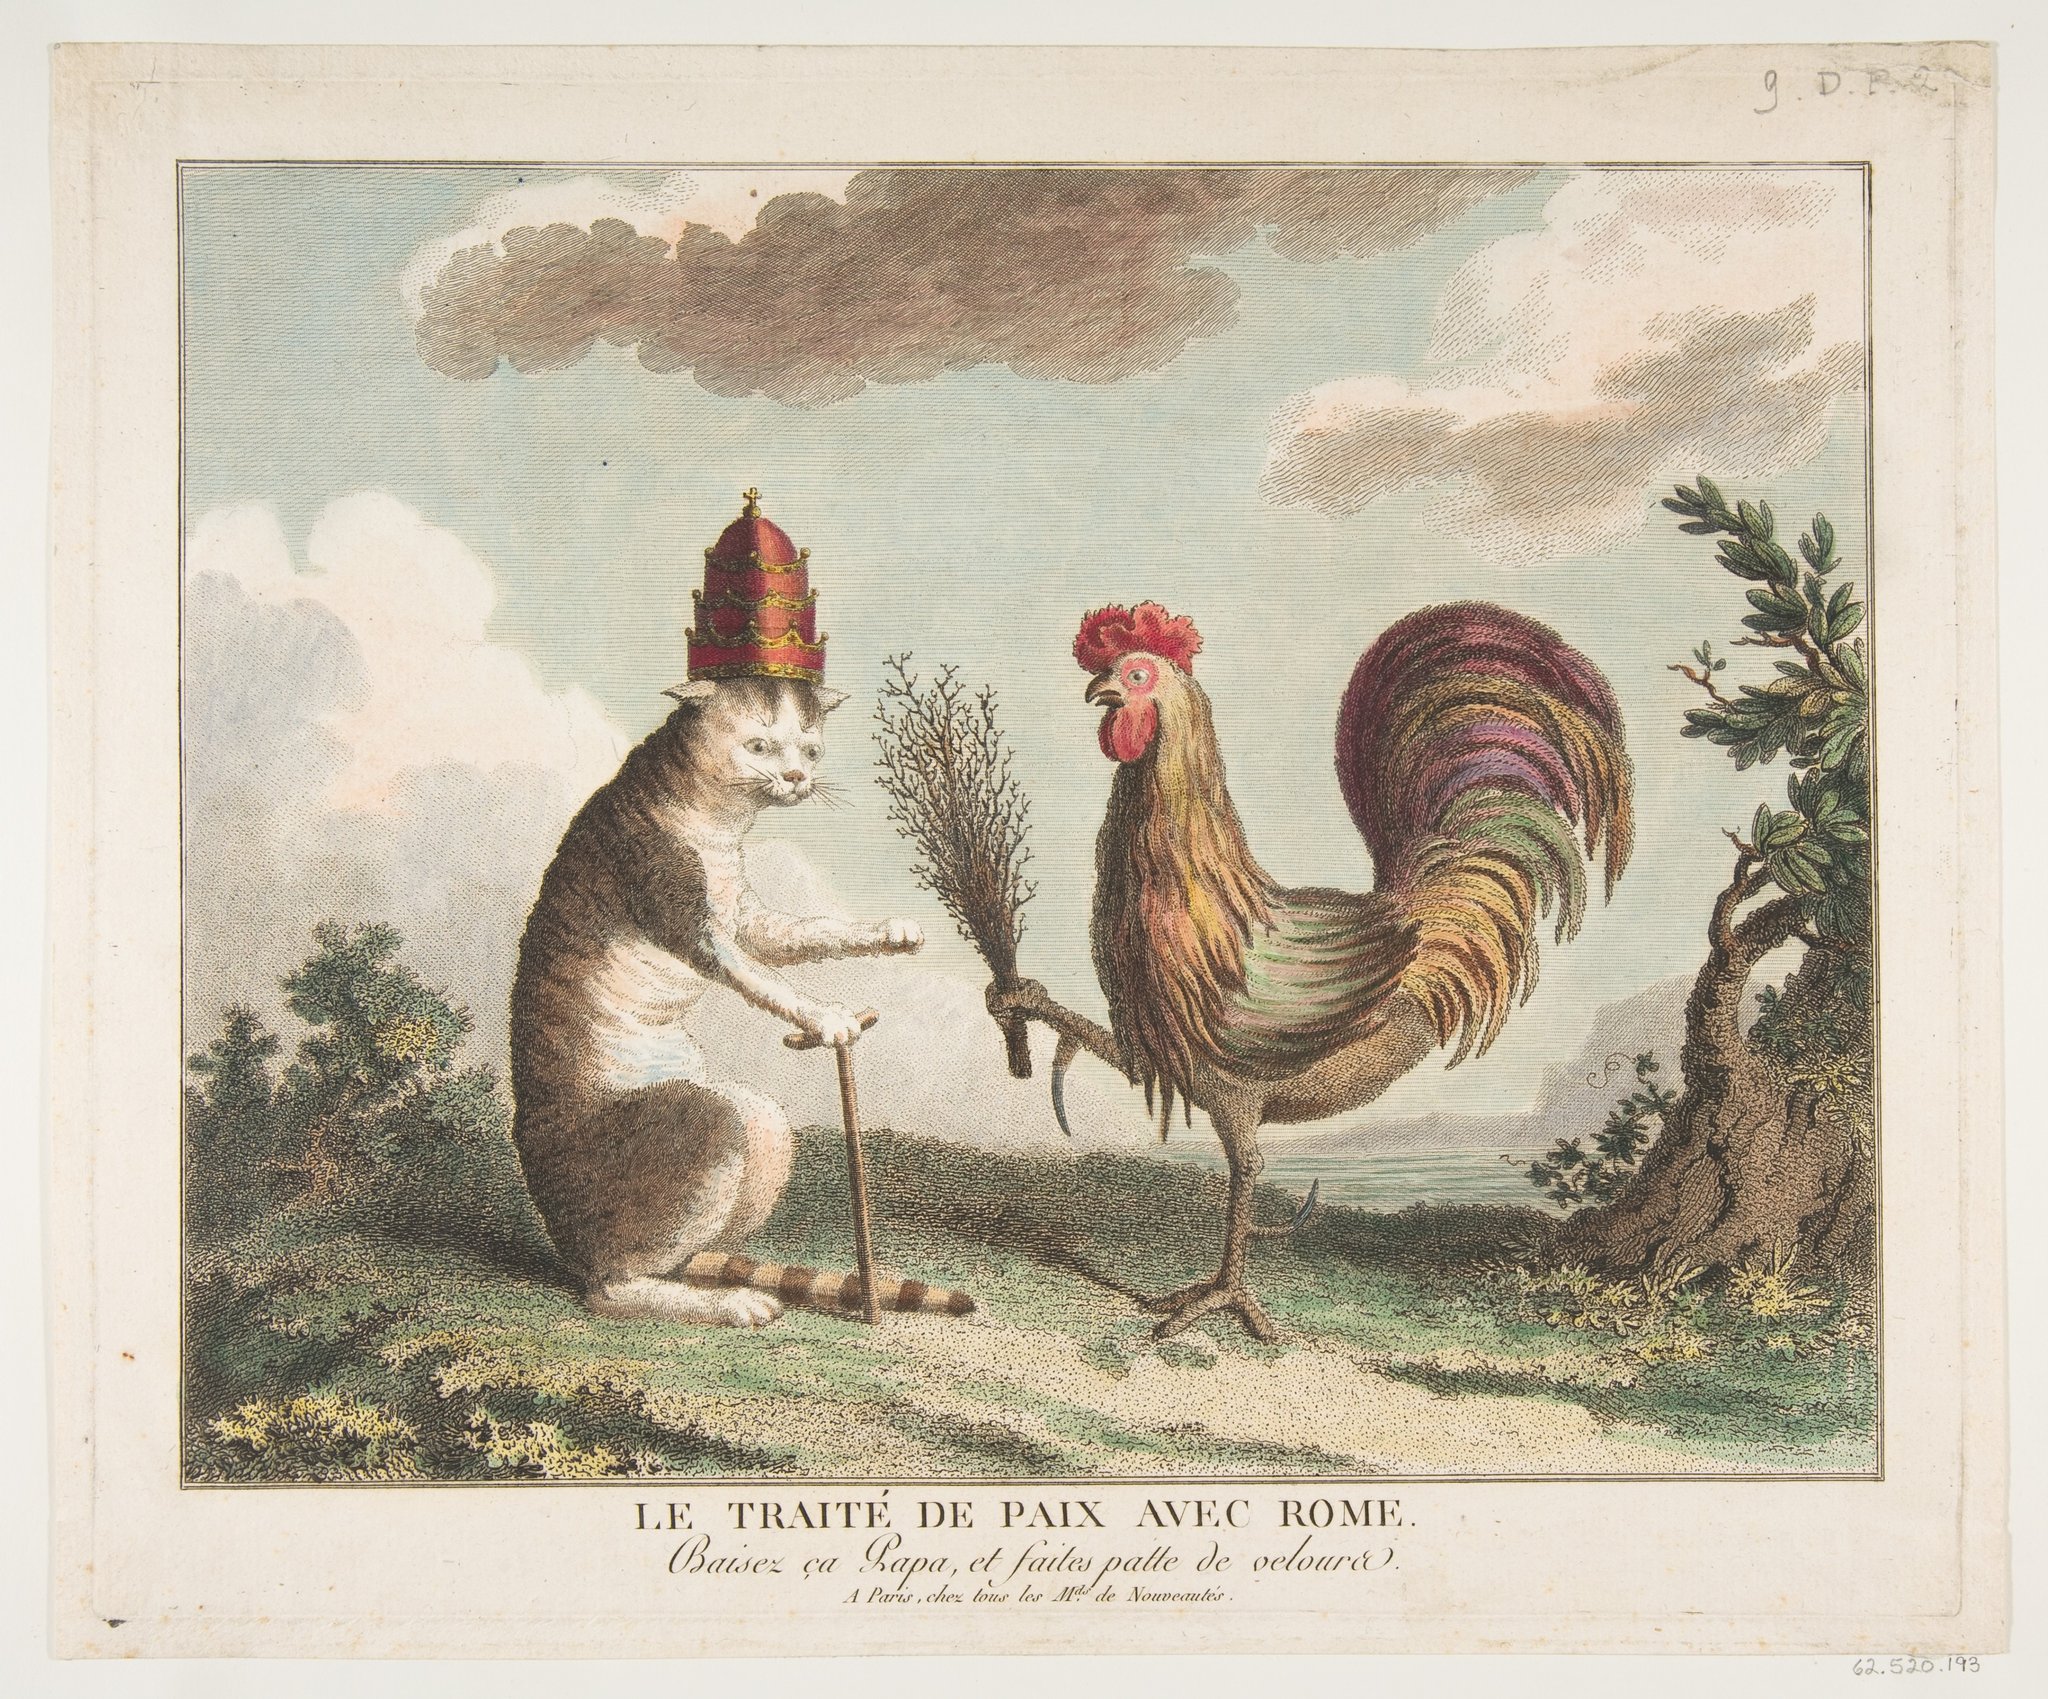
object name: print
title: Le Traité de Paix avec Rome (The Peace Treaty with Rome)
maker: anonymous, french, 18th century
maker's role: artist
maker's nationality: french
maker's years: 1700-1800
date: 1789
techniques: etching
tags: satire,roosters,cats,politics